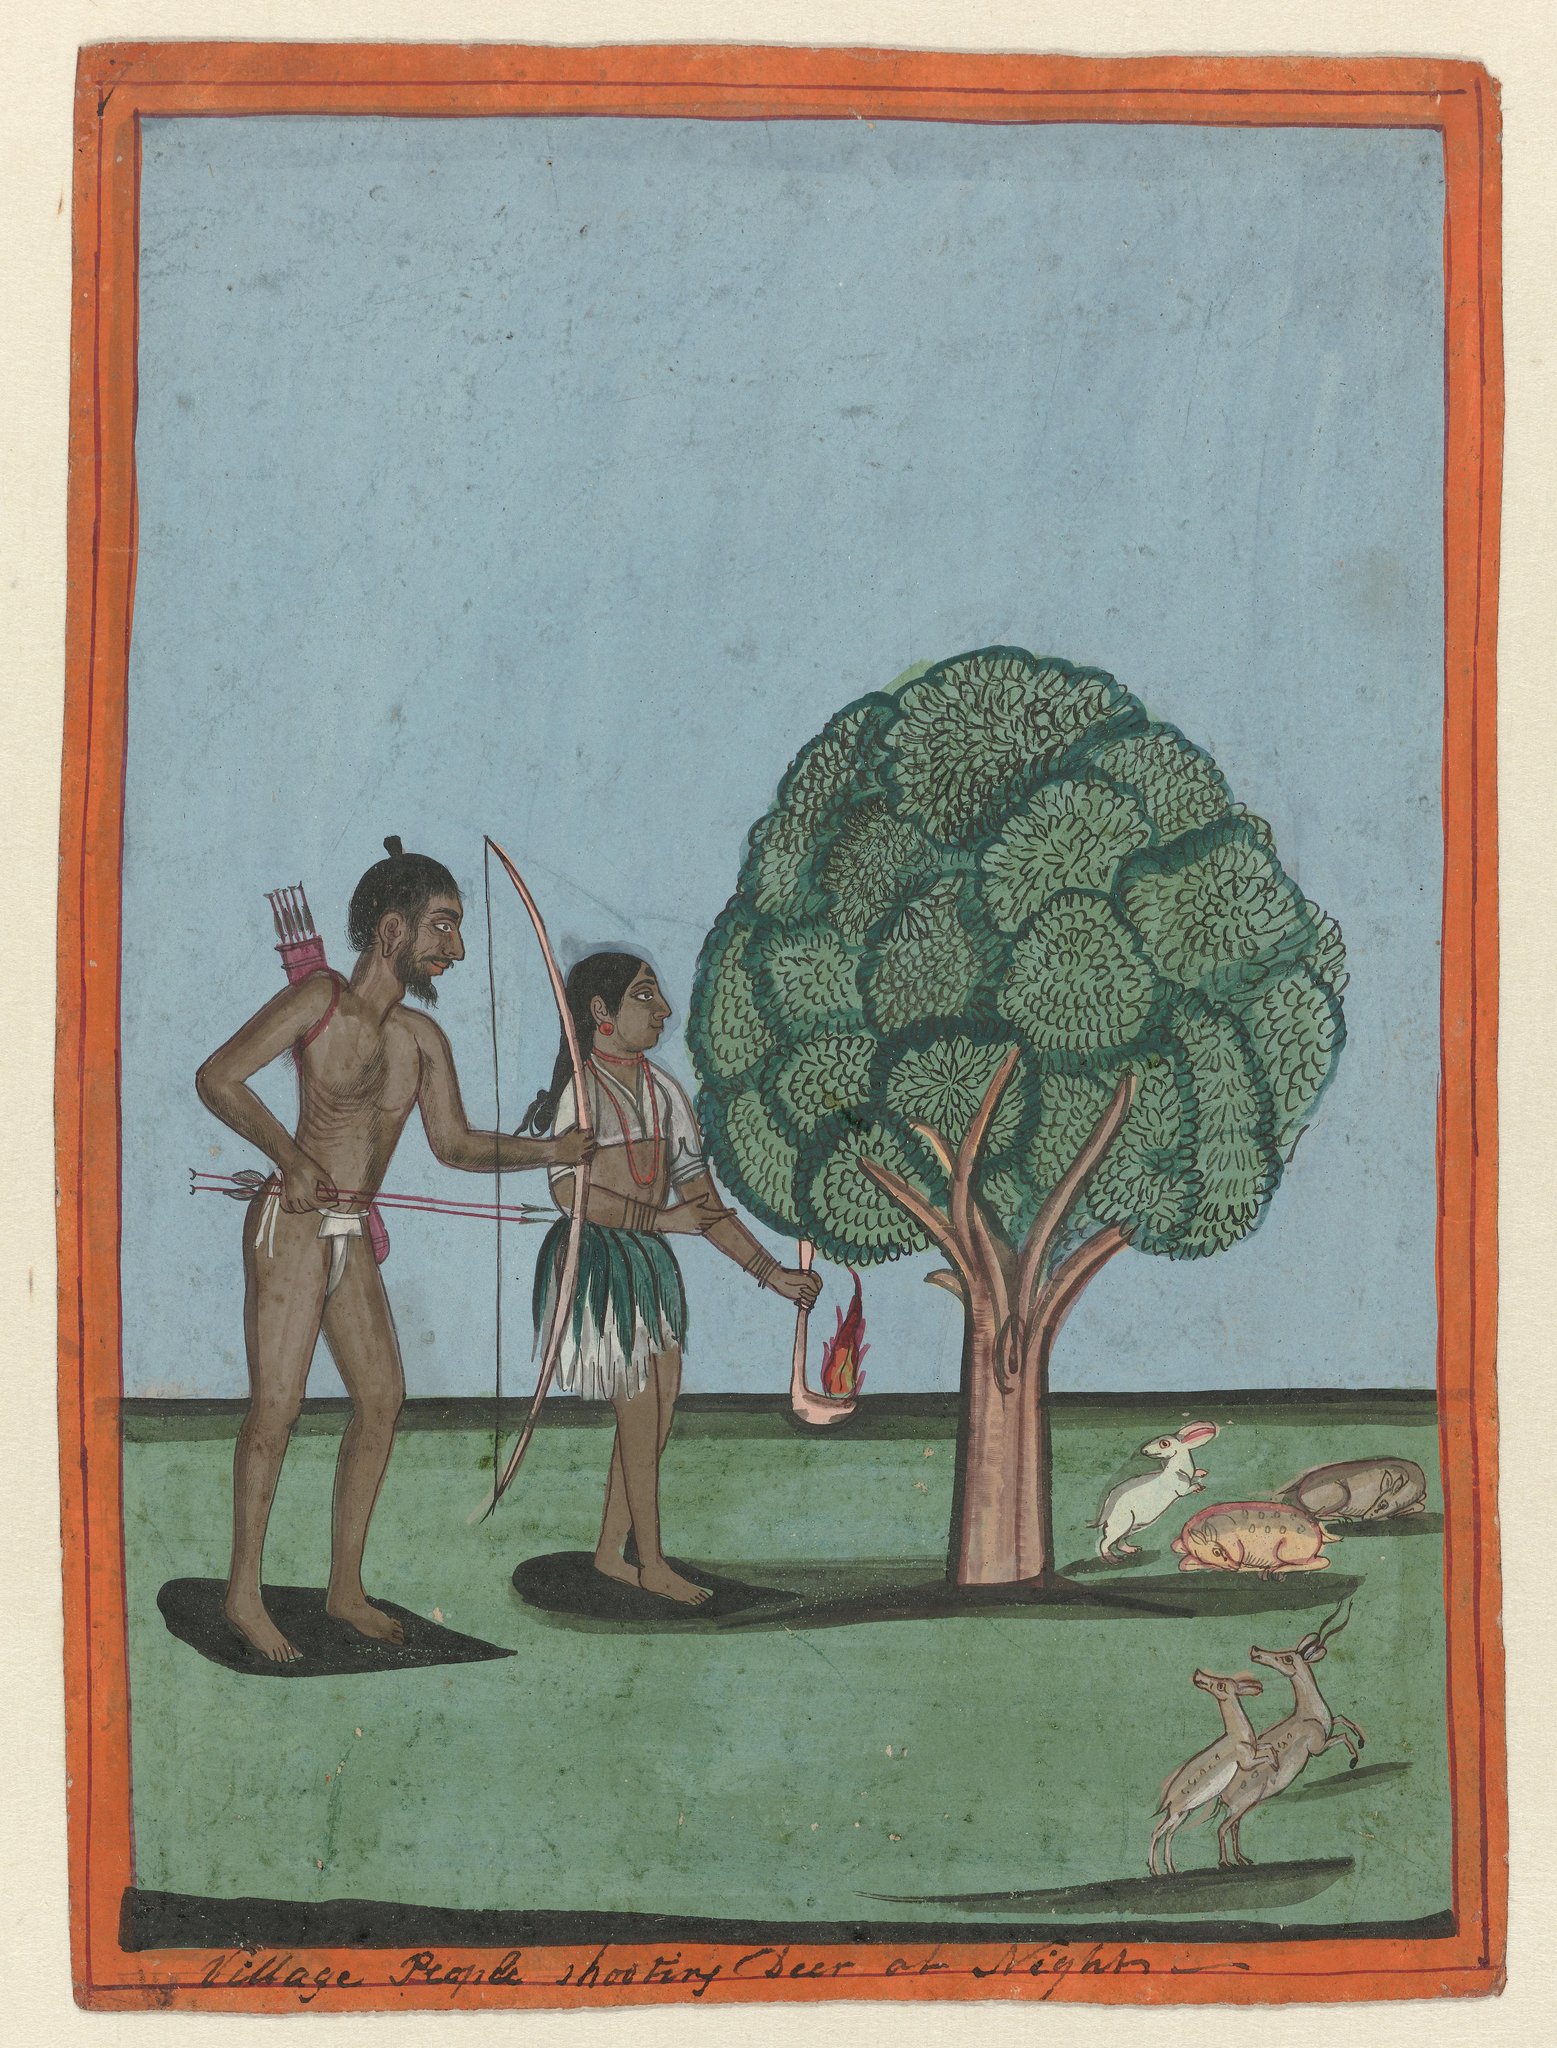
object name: indian miniature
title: Nachtelijke jacht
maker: Anonymous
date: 1800-1900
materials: paper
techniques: brush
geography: chennai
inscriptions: inscription: ‘Village people shooting deer at Night’